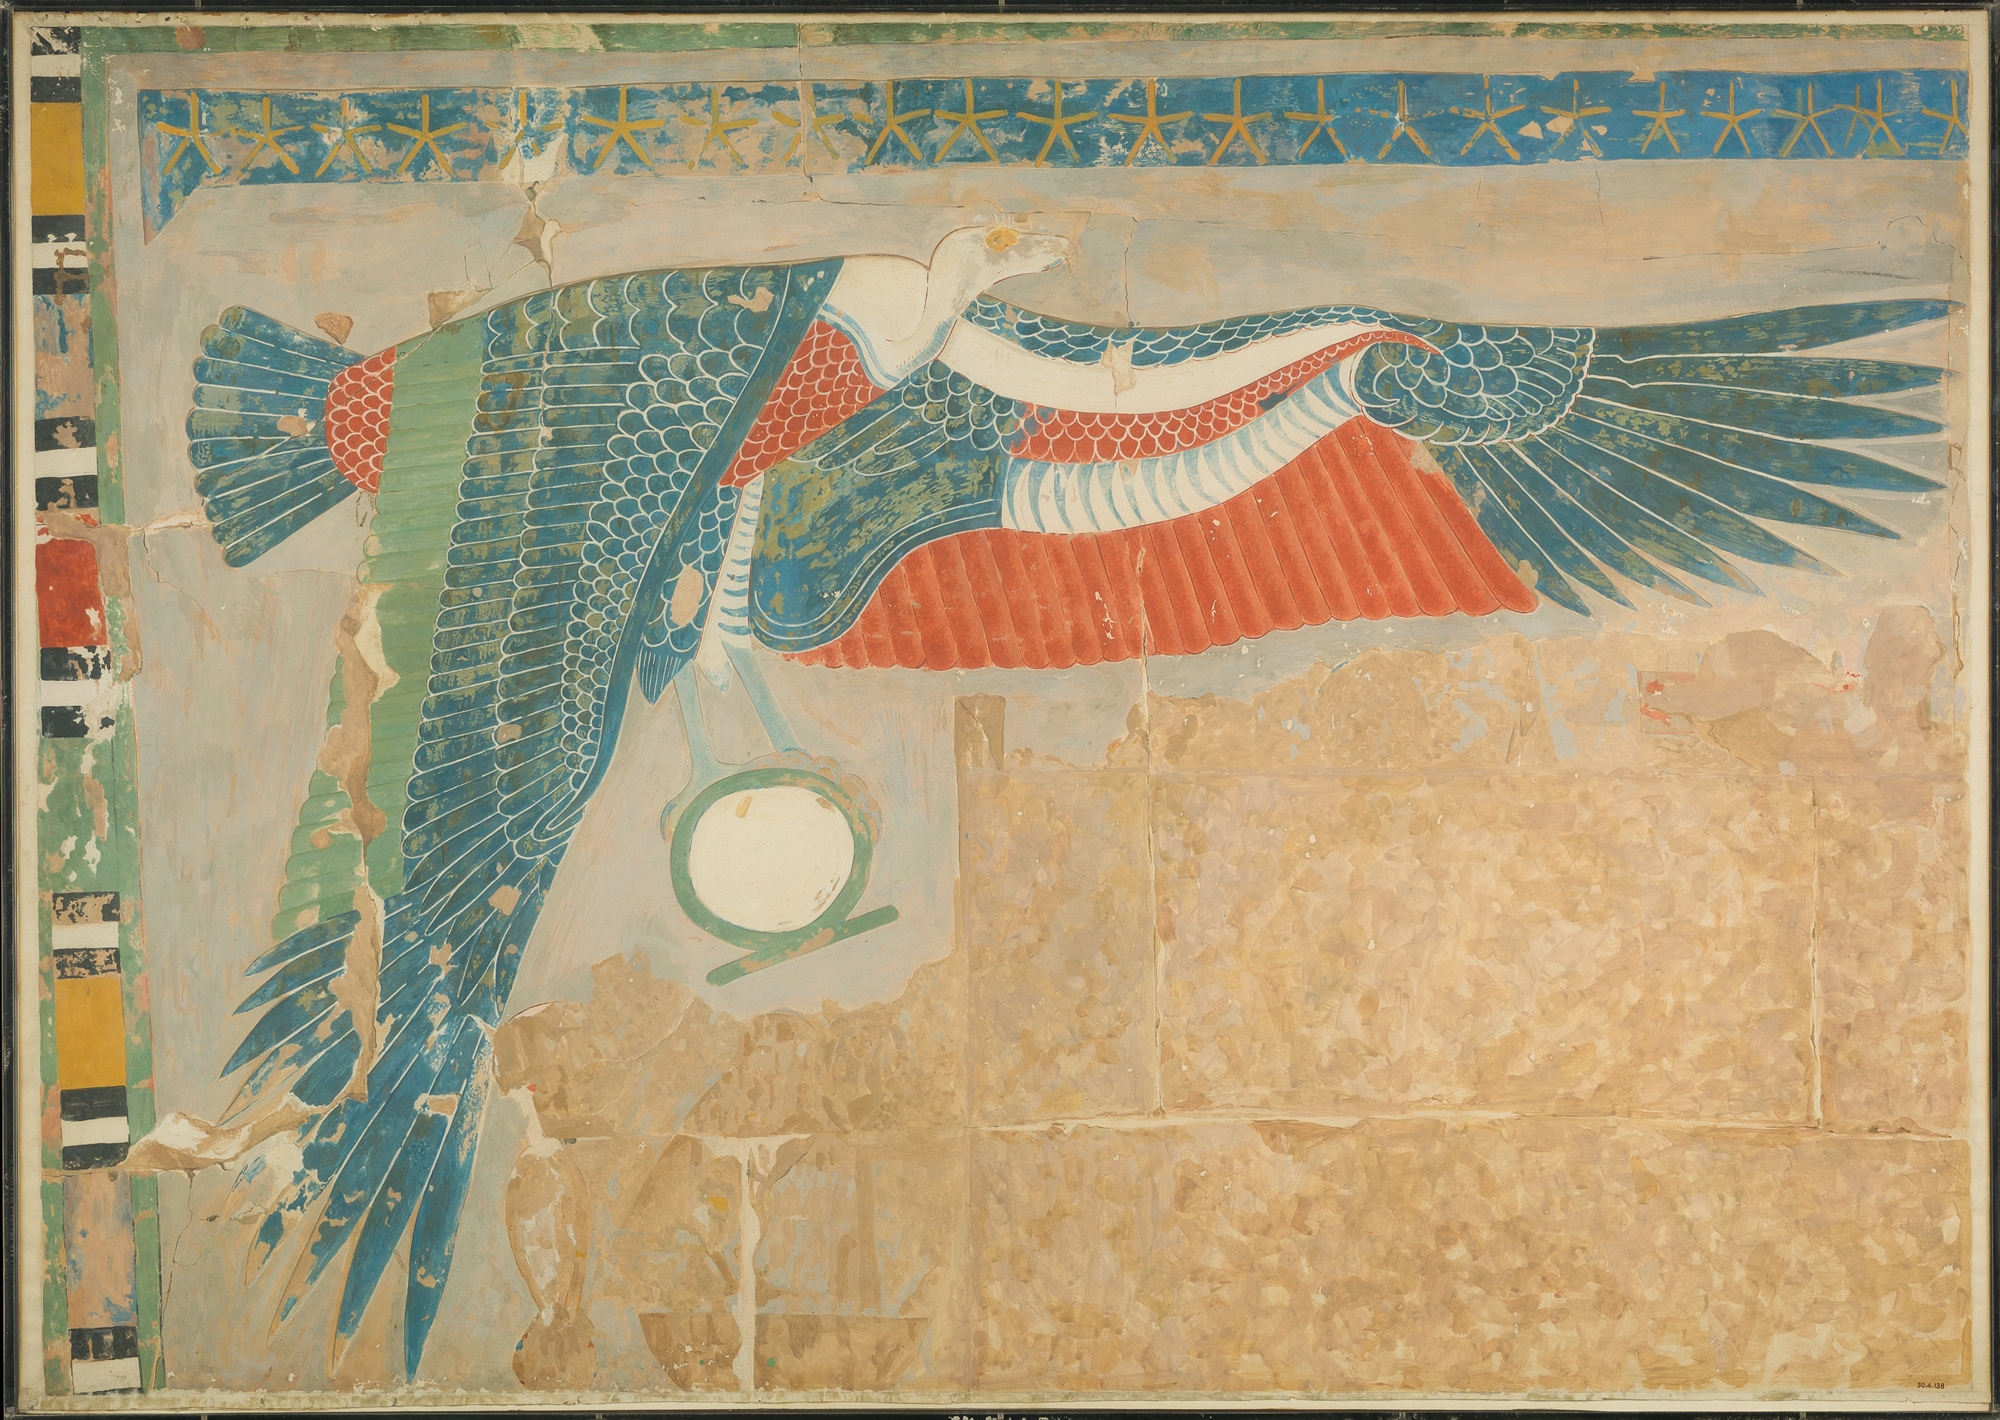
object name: facsimile, hatshepsut temple, nekhbet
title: The Goddess Nekhbet, Temple of Hatshepsut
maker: charles k. wilkinson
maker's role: artist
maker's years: 1897-1986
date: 1479-1458 BCE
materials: paper, paint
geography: egypt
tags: goddess,walk-like-egyptian